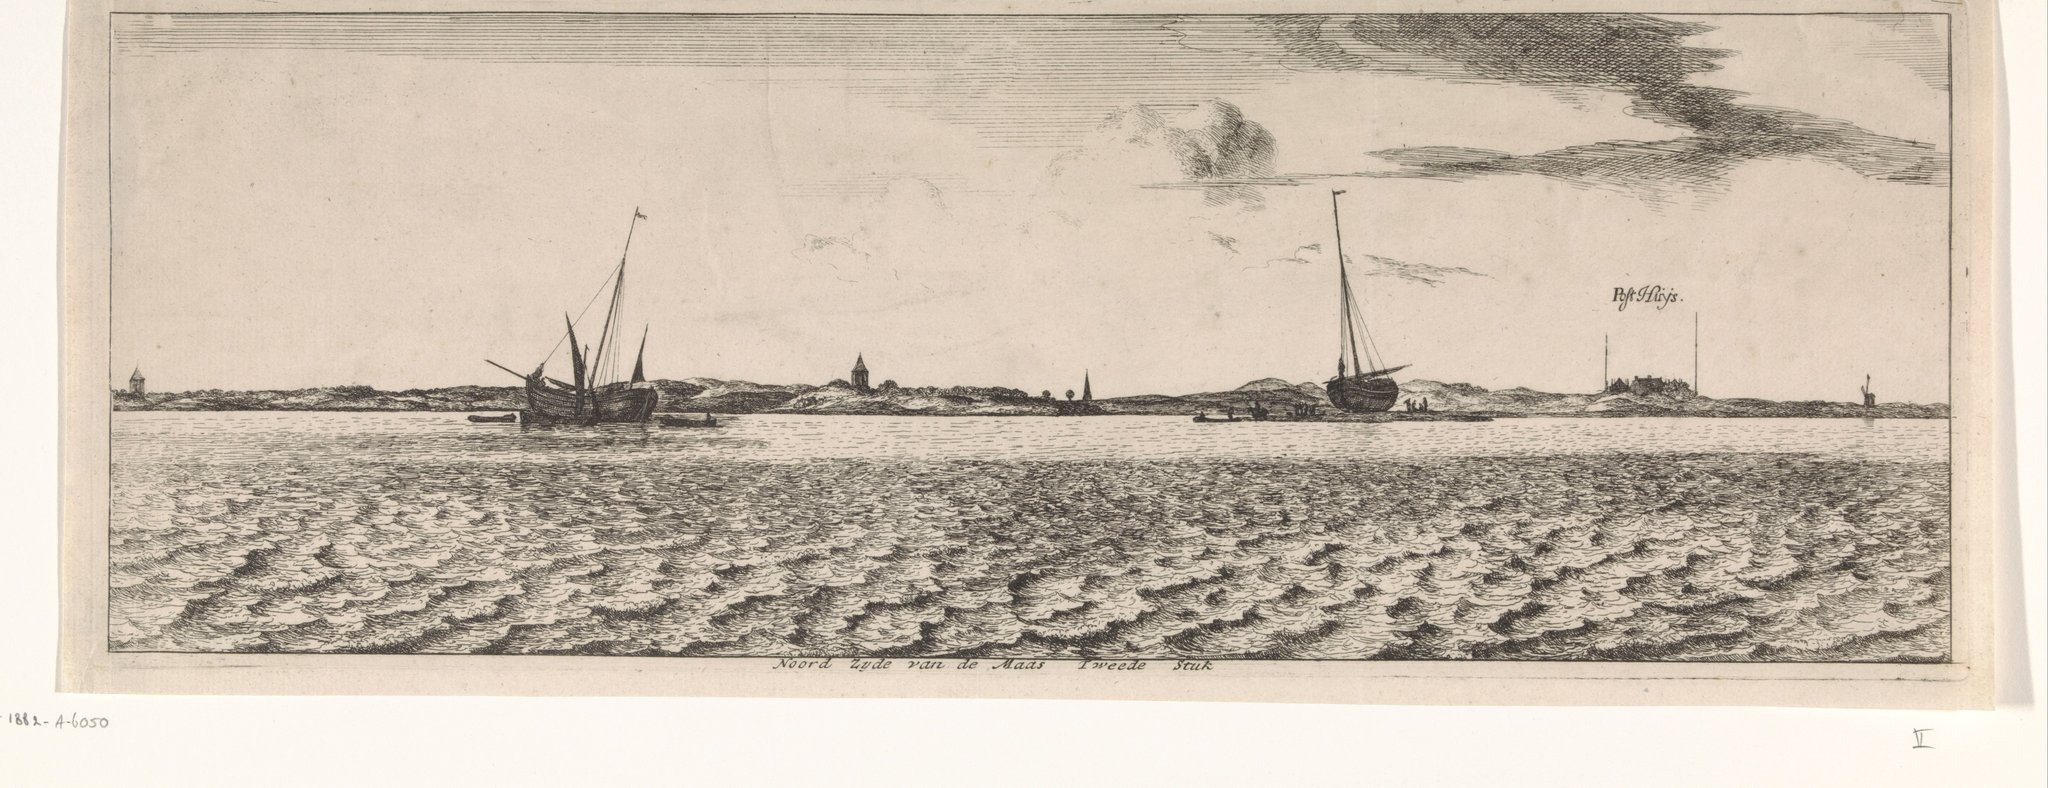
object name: print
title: Postkaart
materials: paper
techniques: engraving, etching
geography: rotterdam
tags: post-office, city-view in general; 'veduta', river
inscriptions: collector's mark: Lugt 2228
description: Gezicht op de noordzijde van de Maas met op de achtergrond een postkantoor aan de oever.